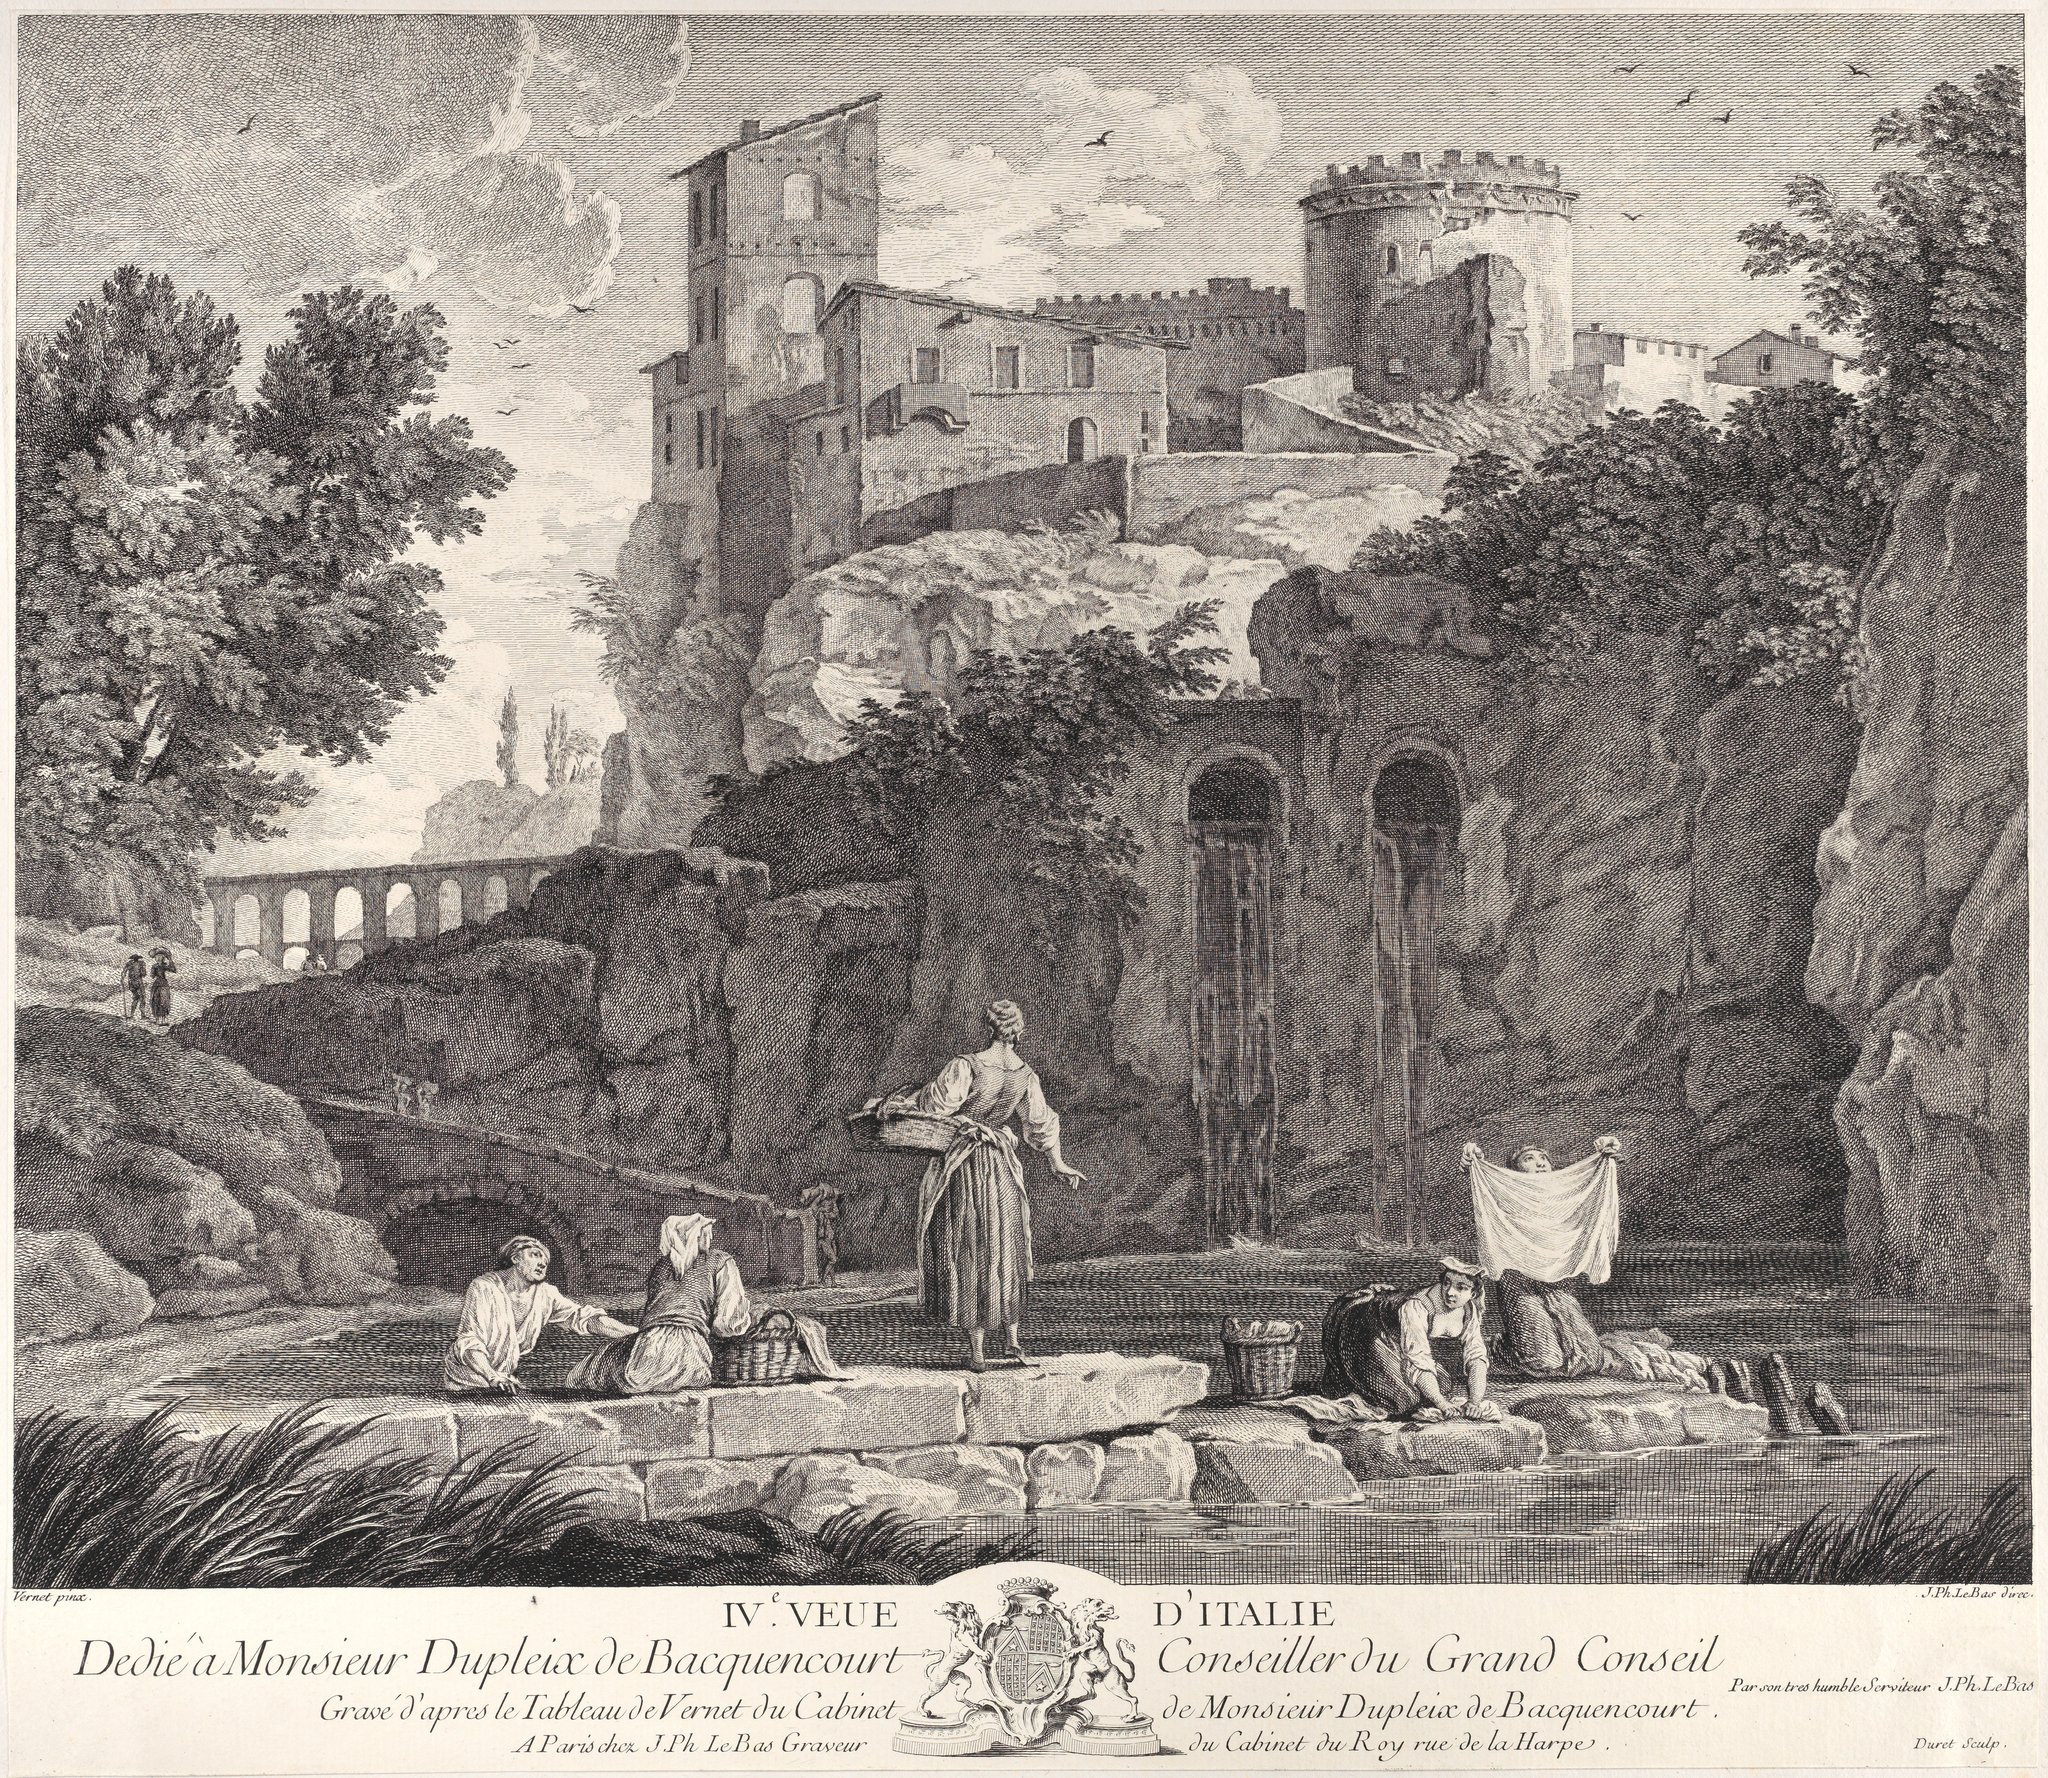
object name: print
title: Fourth View of Italy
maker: joseph vernet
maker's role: artist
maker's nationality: french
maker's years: 1714-1789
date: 1750-1800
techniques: engraving